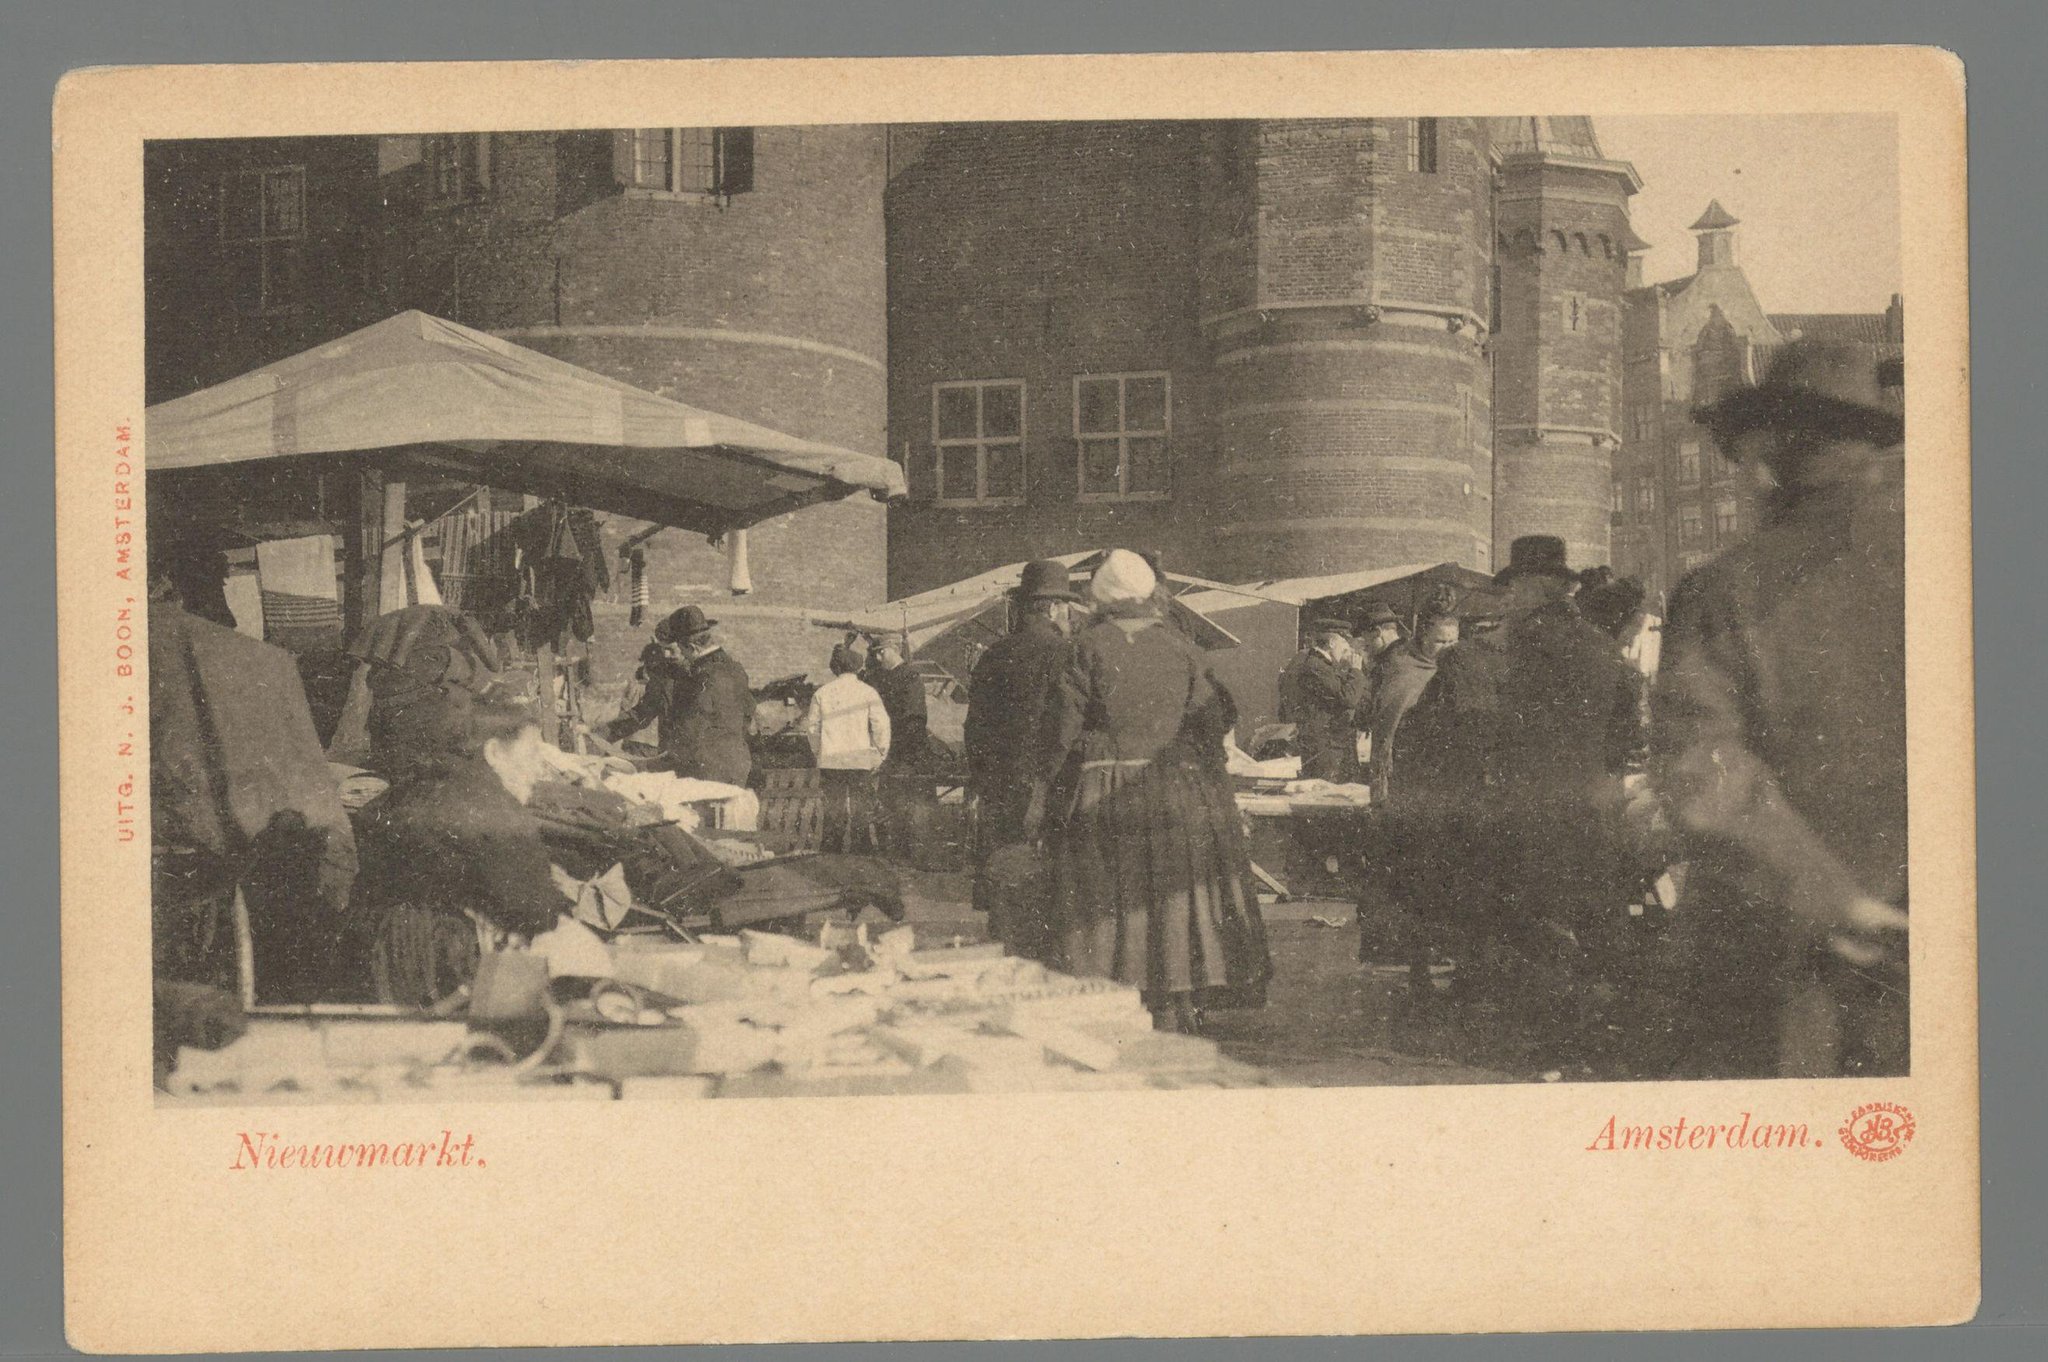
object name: photomechanical print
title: Nieuwmarkt. Amsterdam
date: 1892-1905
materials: cardboard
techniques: photograph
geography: amsterdam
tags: market, amsterdam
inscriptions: collector's mark: Lugt 2228